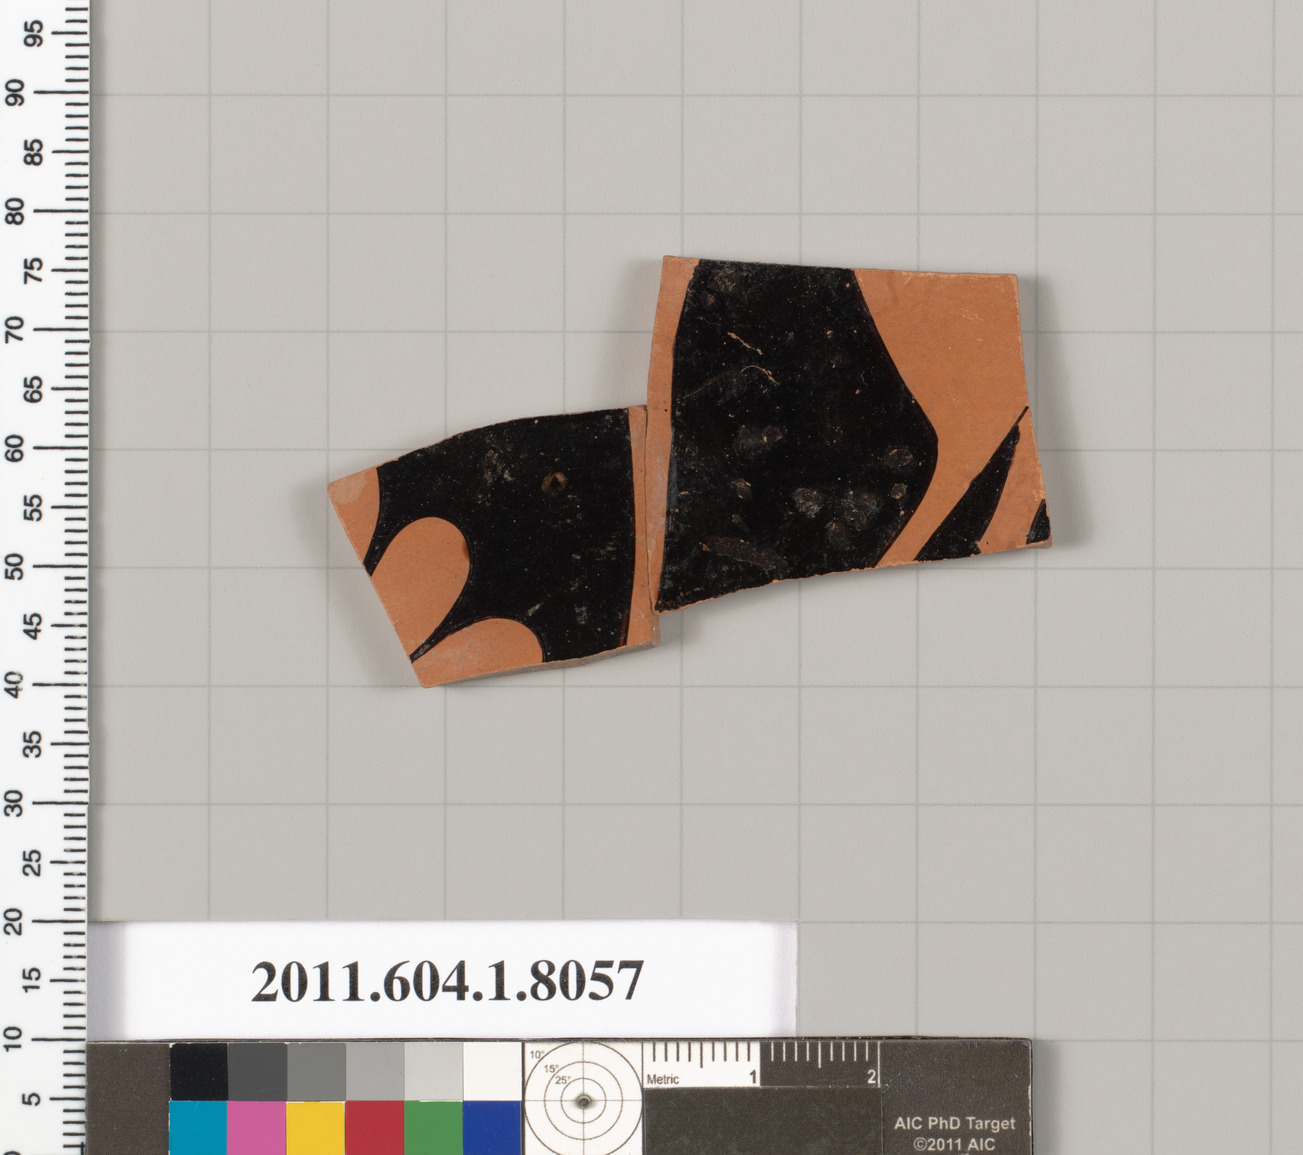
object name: kylix fragment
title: Terracotta fragment of a kylix (drinking cup)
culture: greek, attic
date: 510-500 BCE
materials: terracotta